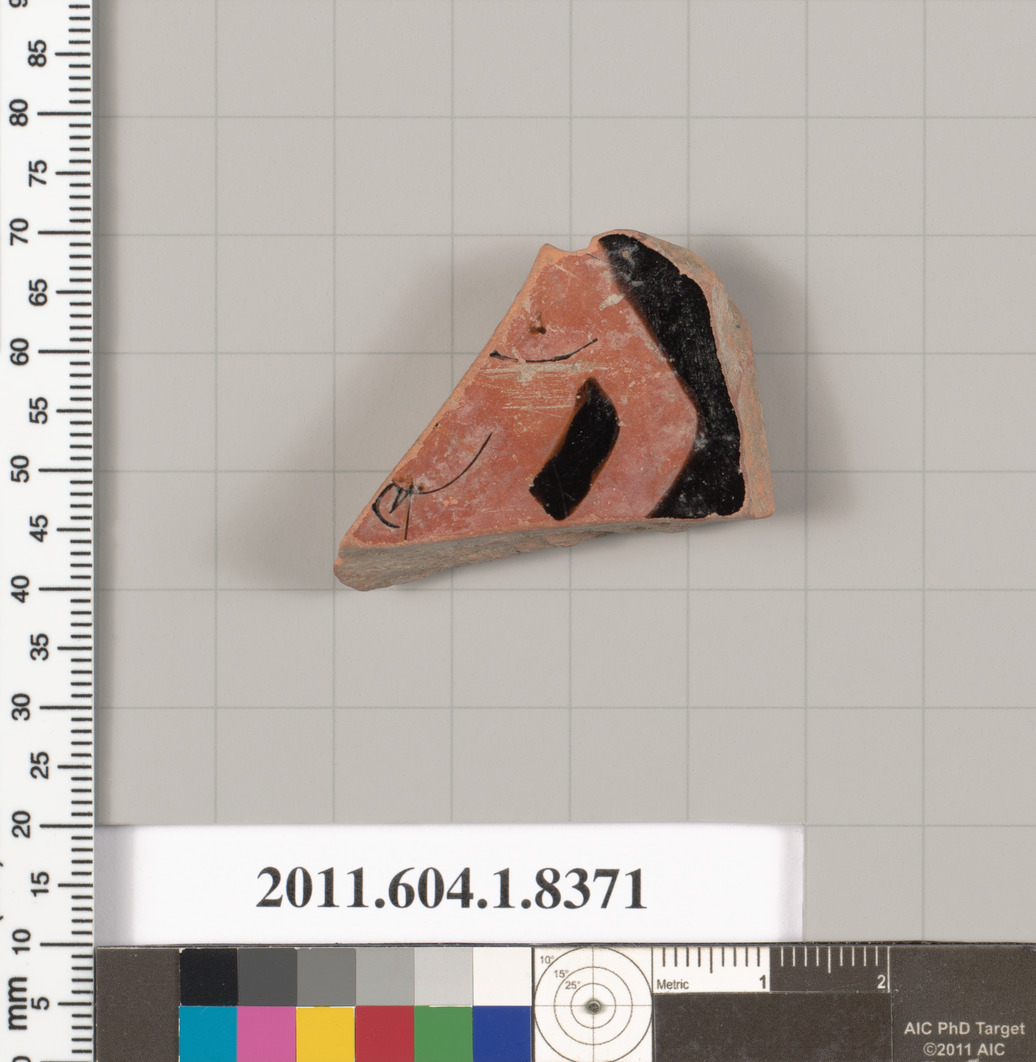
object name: kylix fragment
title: Terracotta fragment of a kylix (drinking cup)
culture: greek, attic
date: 400-351 BCE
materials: terracotta